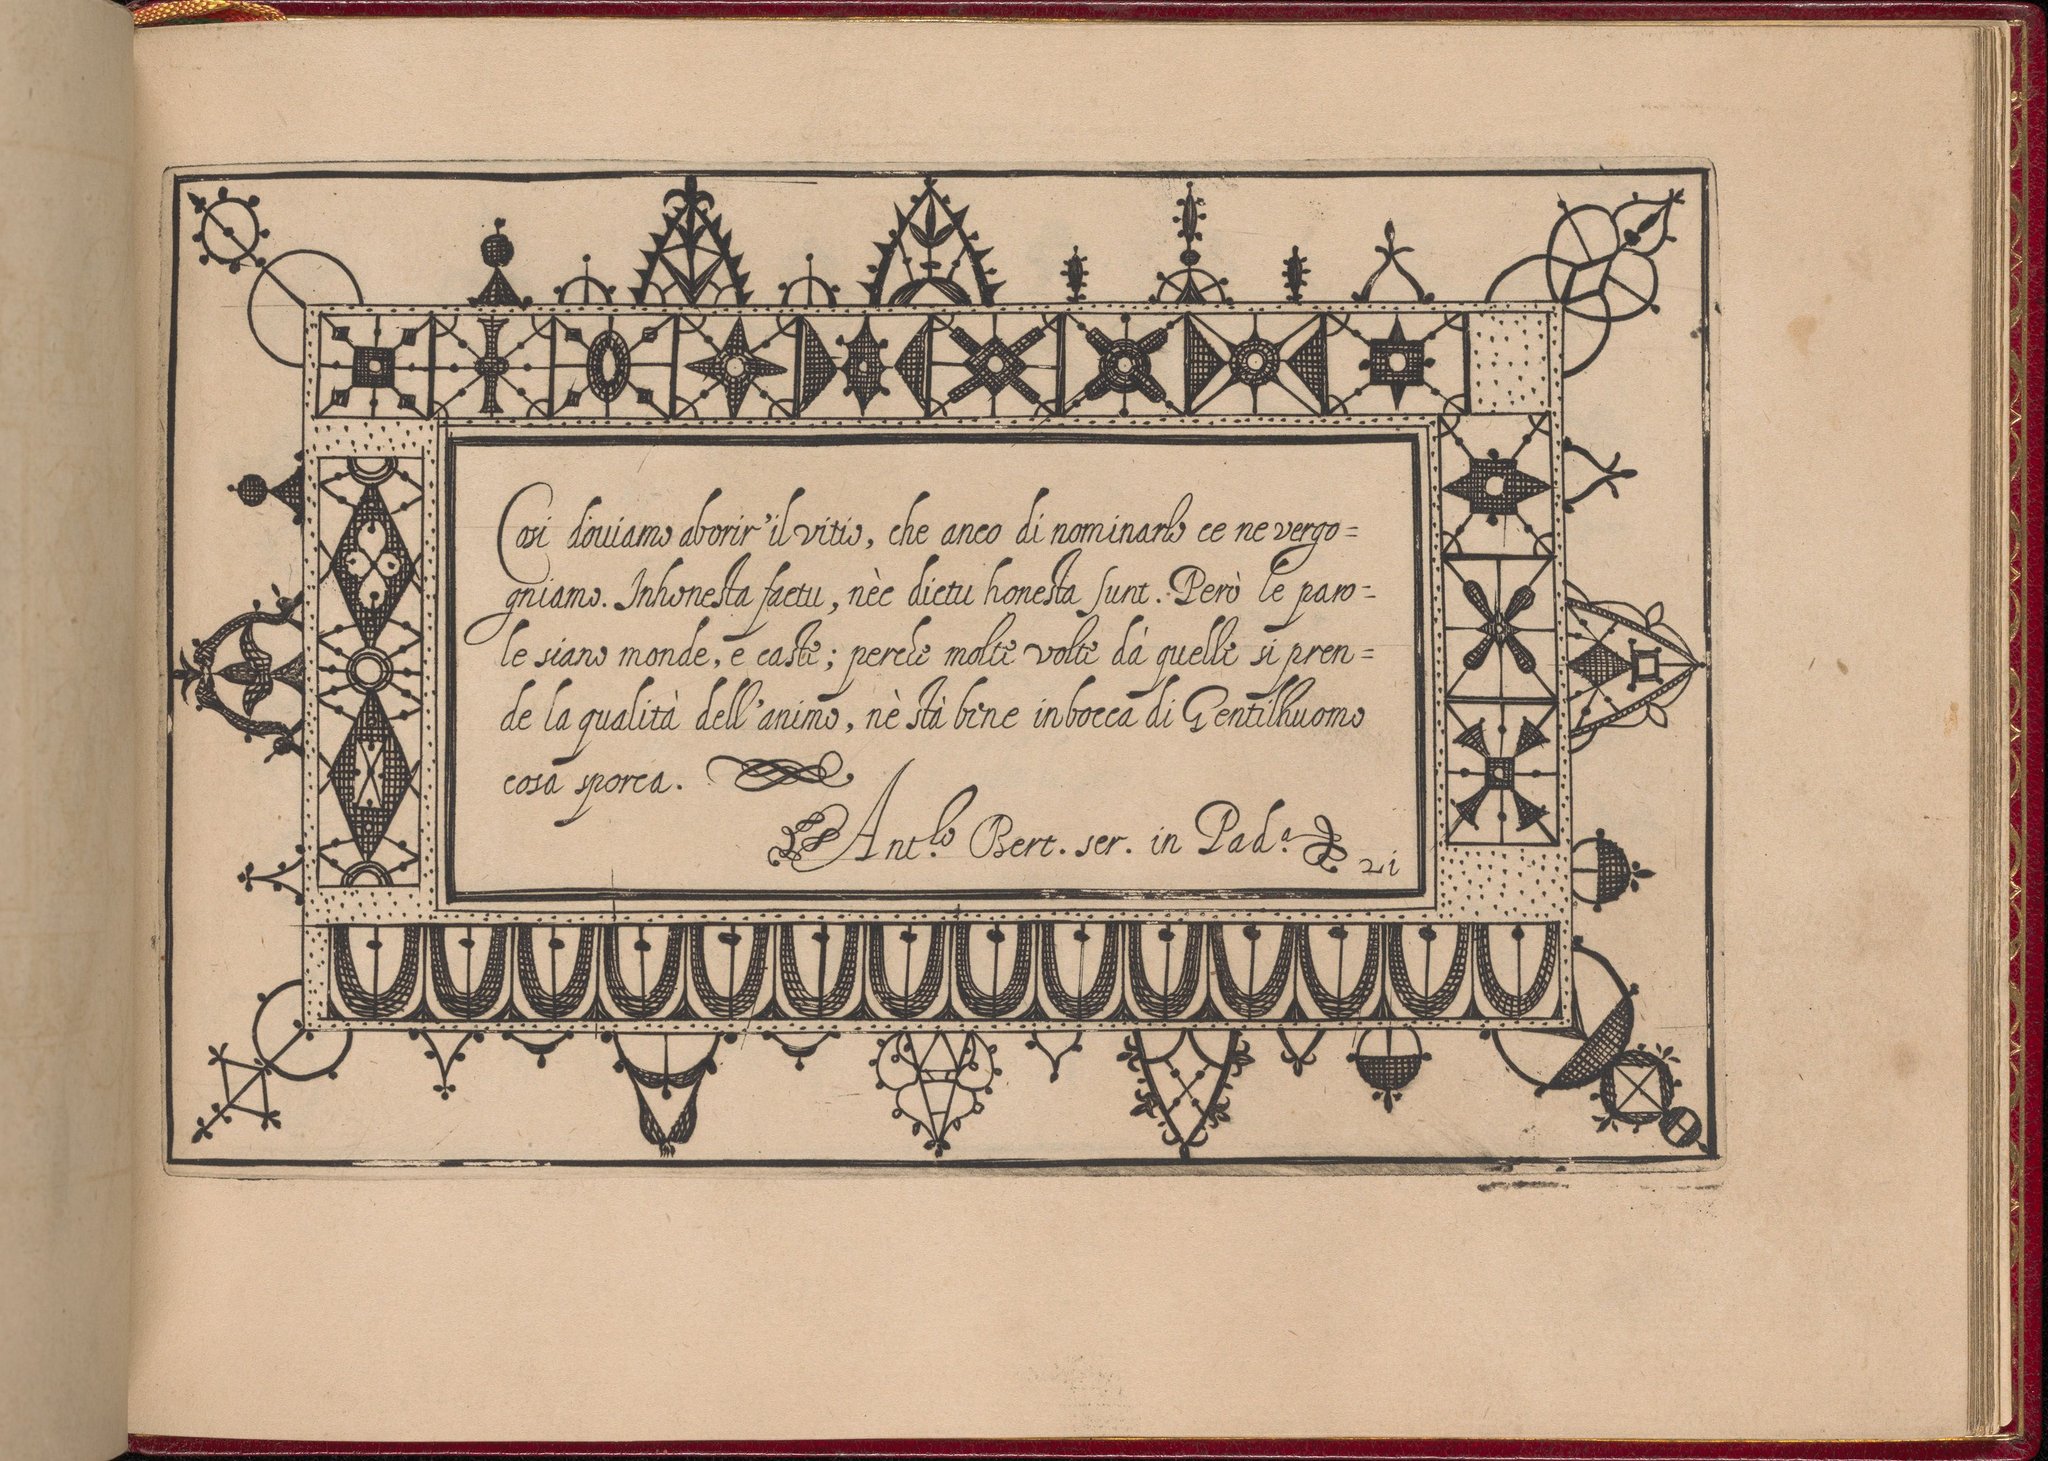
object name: book print ornament architecture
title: Ghirlanda: Di sei vaghi fiori scielti da piu famosi Giardini d'Italia, page 29 (recto)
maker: pietro paulo tozzi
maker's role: designer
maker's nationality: italian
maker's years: 1593-1628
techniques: drawing, etching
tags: ornament